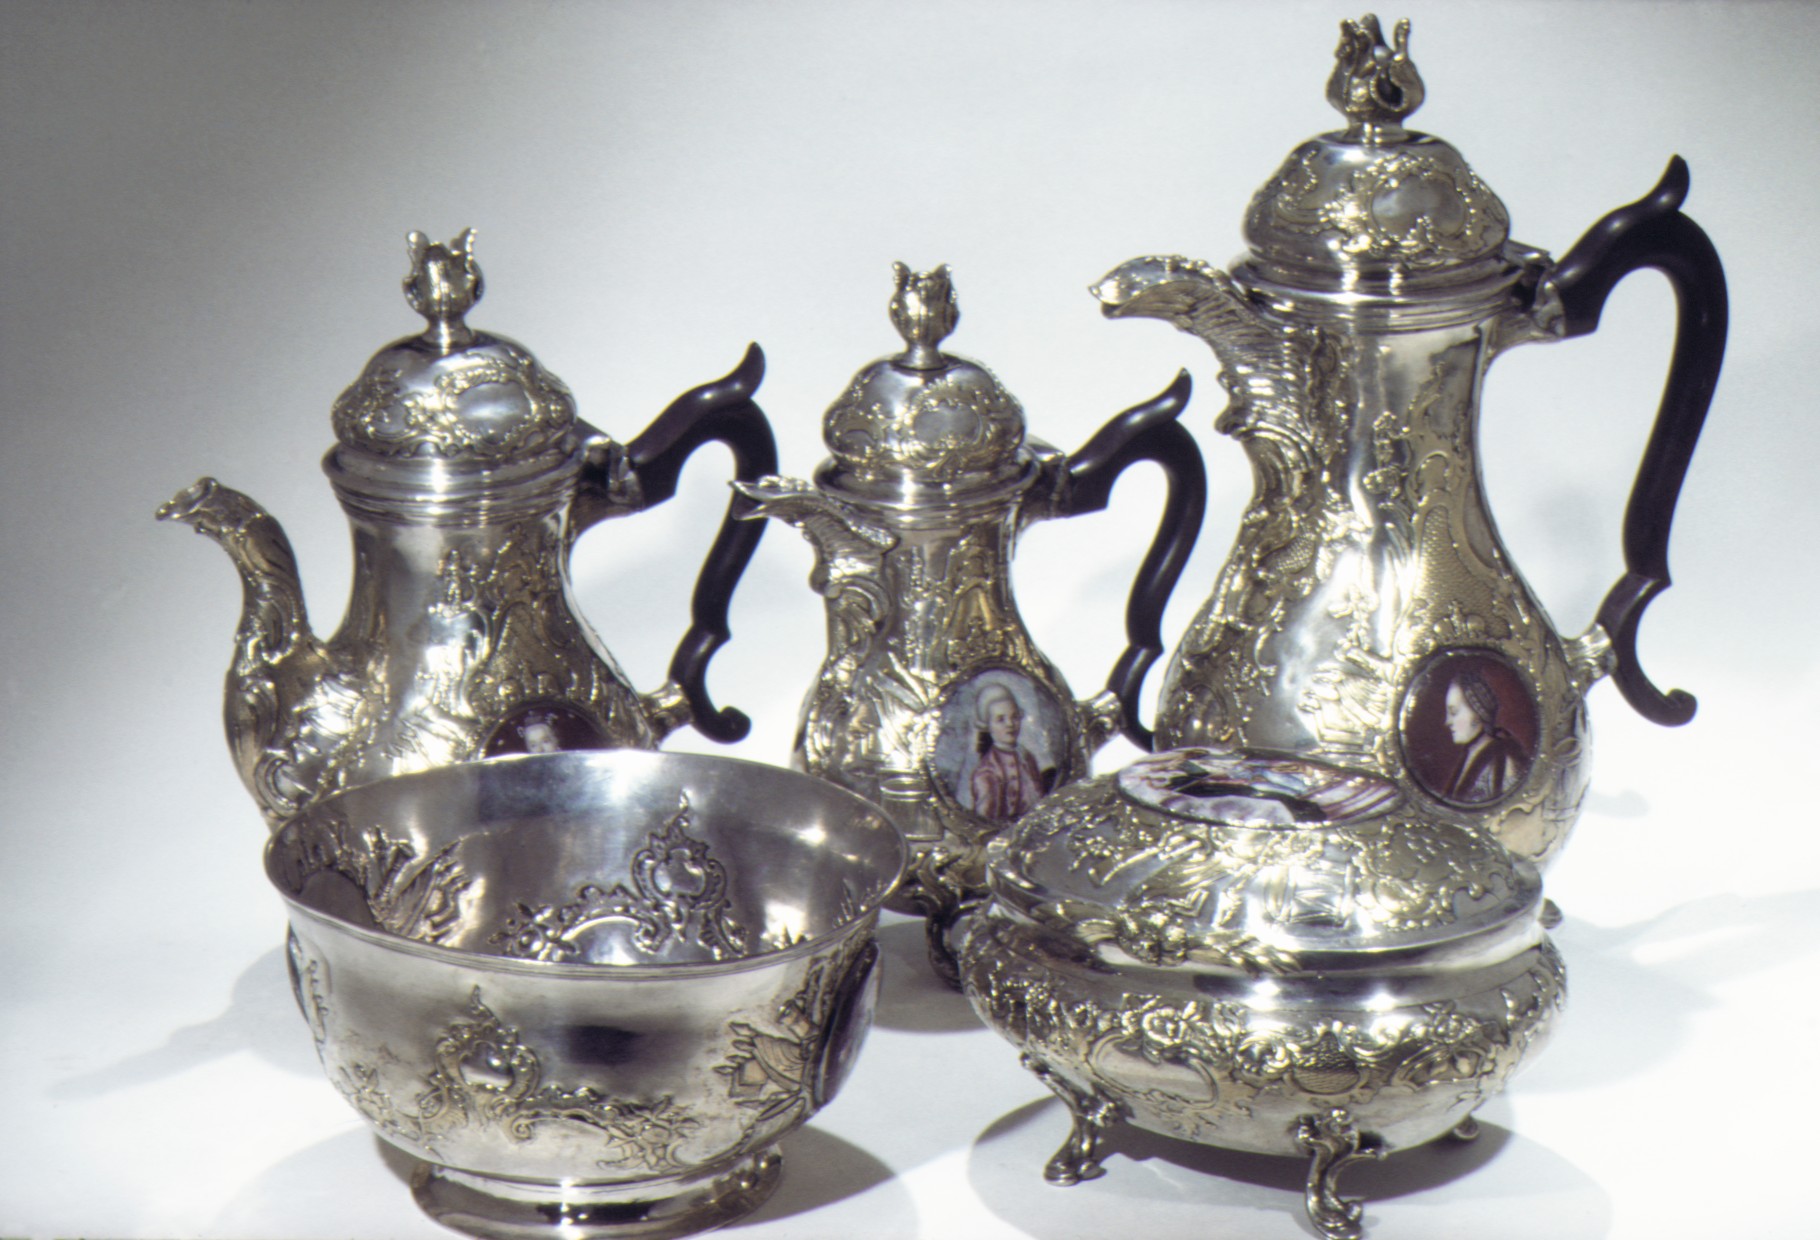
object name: coffee service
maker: johan henrik blom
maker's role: maker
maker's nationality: finish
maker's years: 1705-1805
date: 1773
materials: enamel, gilt, silver, wood